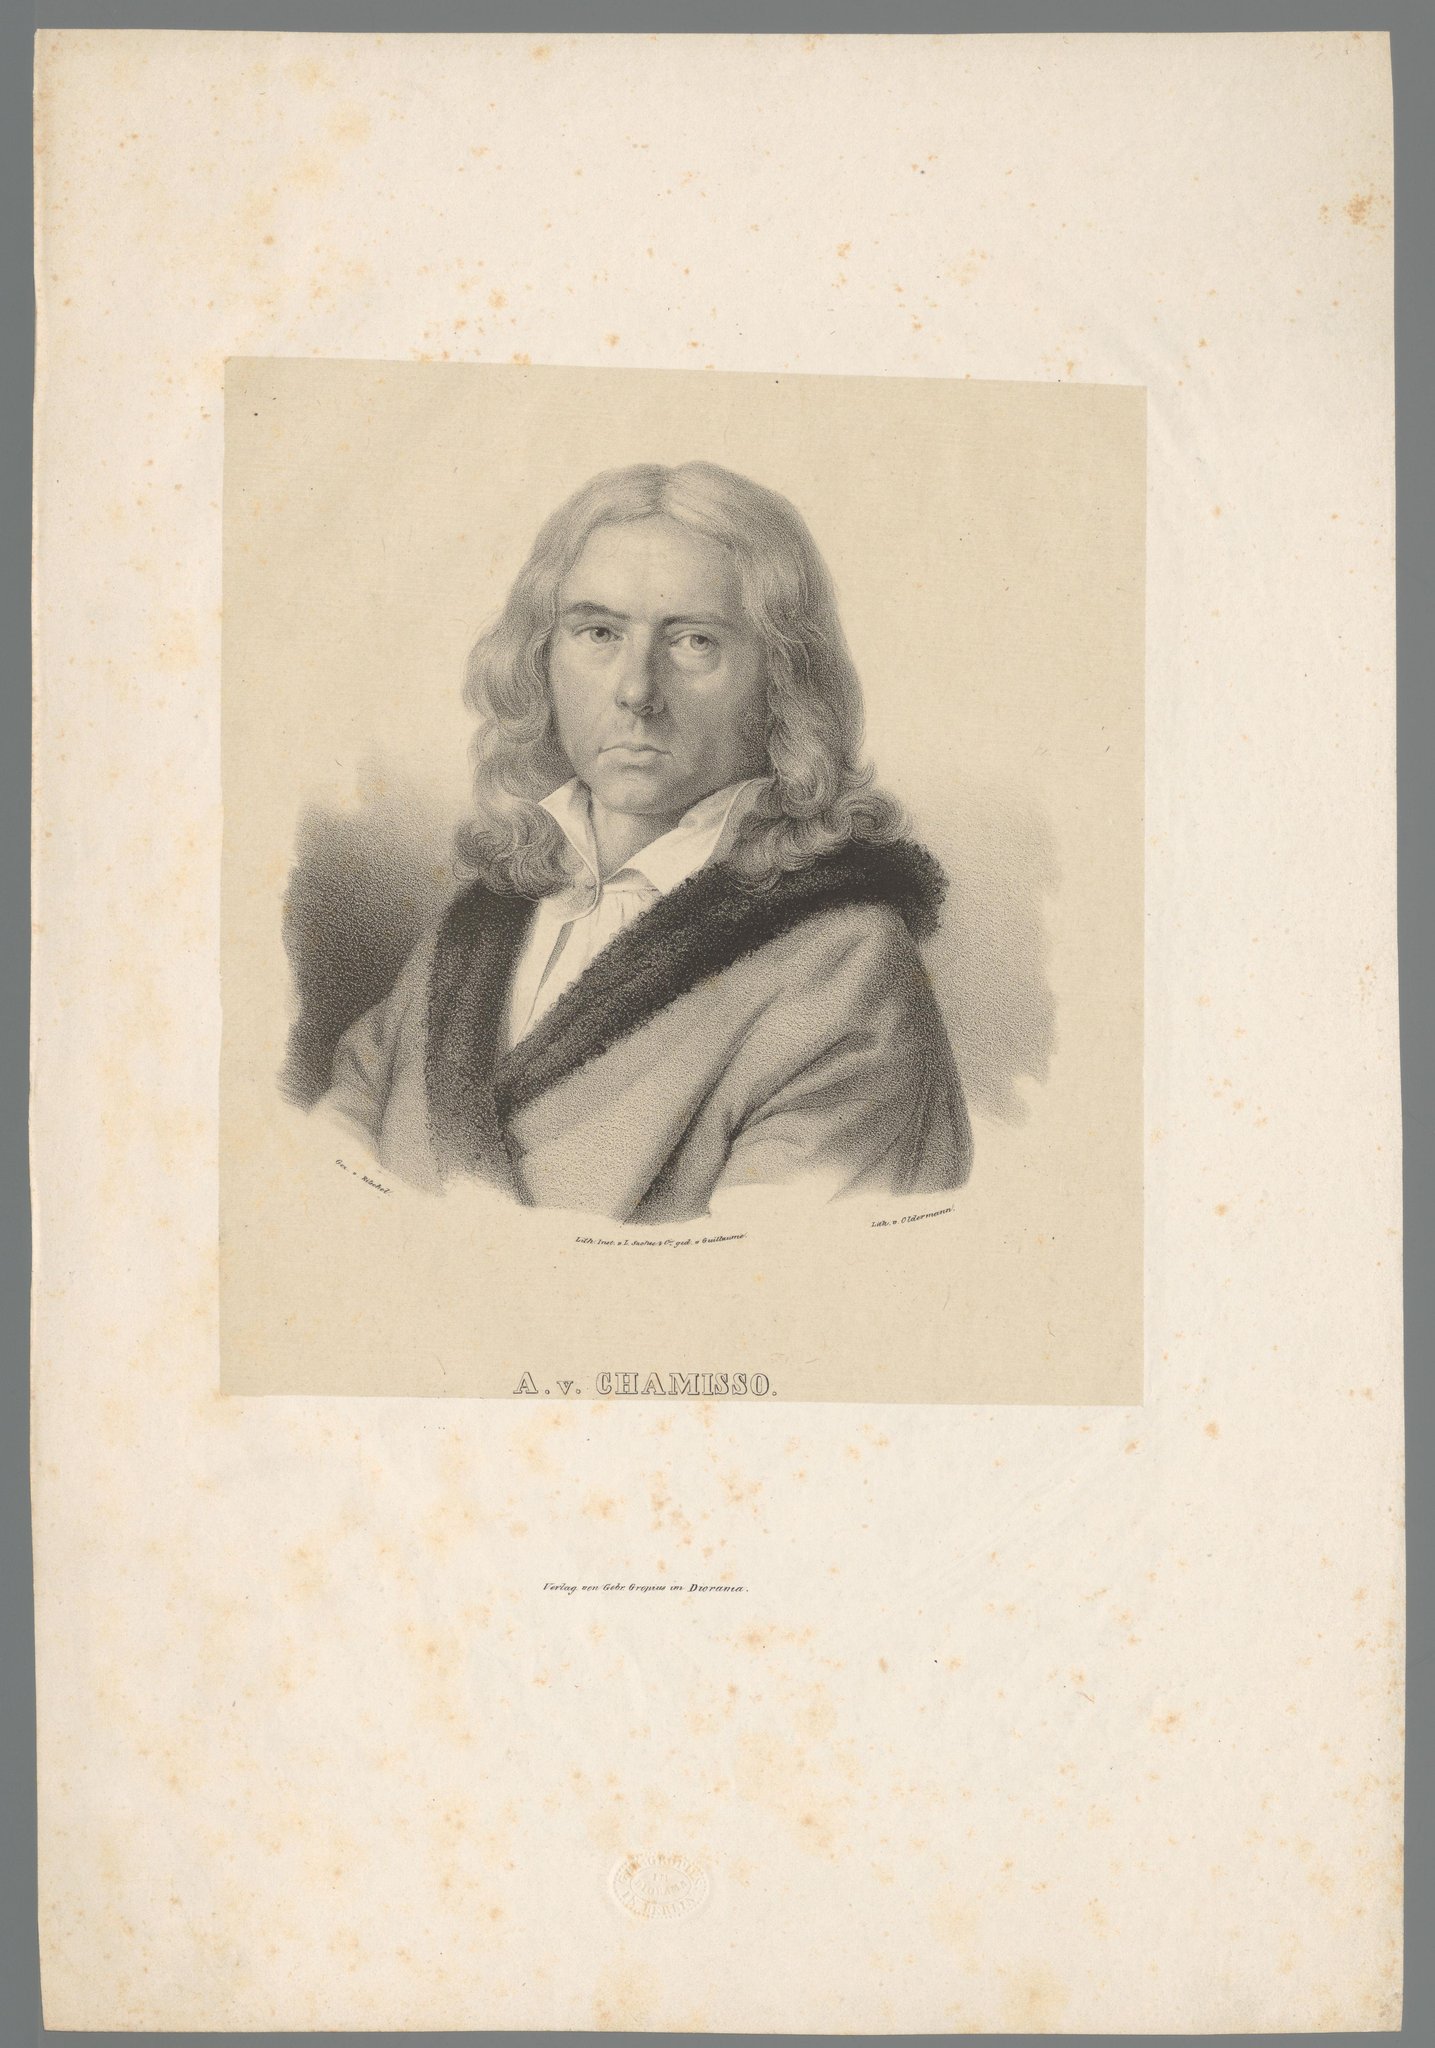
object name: print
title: Portret van Adelbert von Chamisso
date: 1820-1850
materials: paper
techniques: lithograph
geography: berlin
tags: berlin, adelbert von chamisso, adult man, historical persons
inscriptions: check stamp: Lugt 5415, collector's mark: Lugt 2228